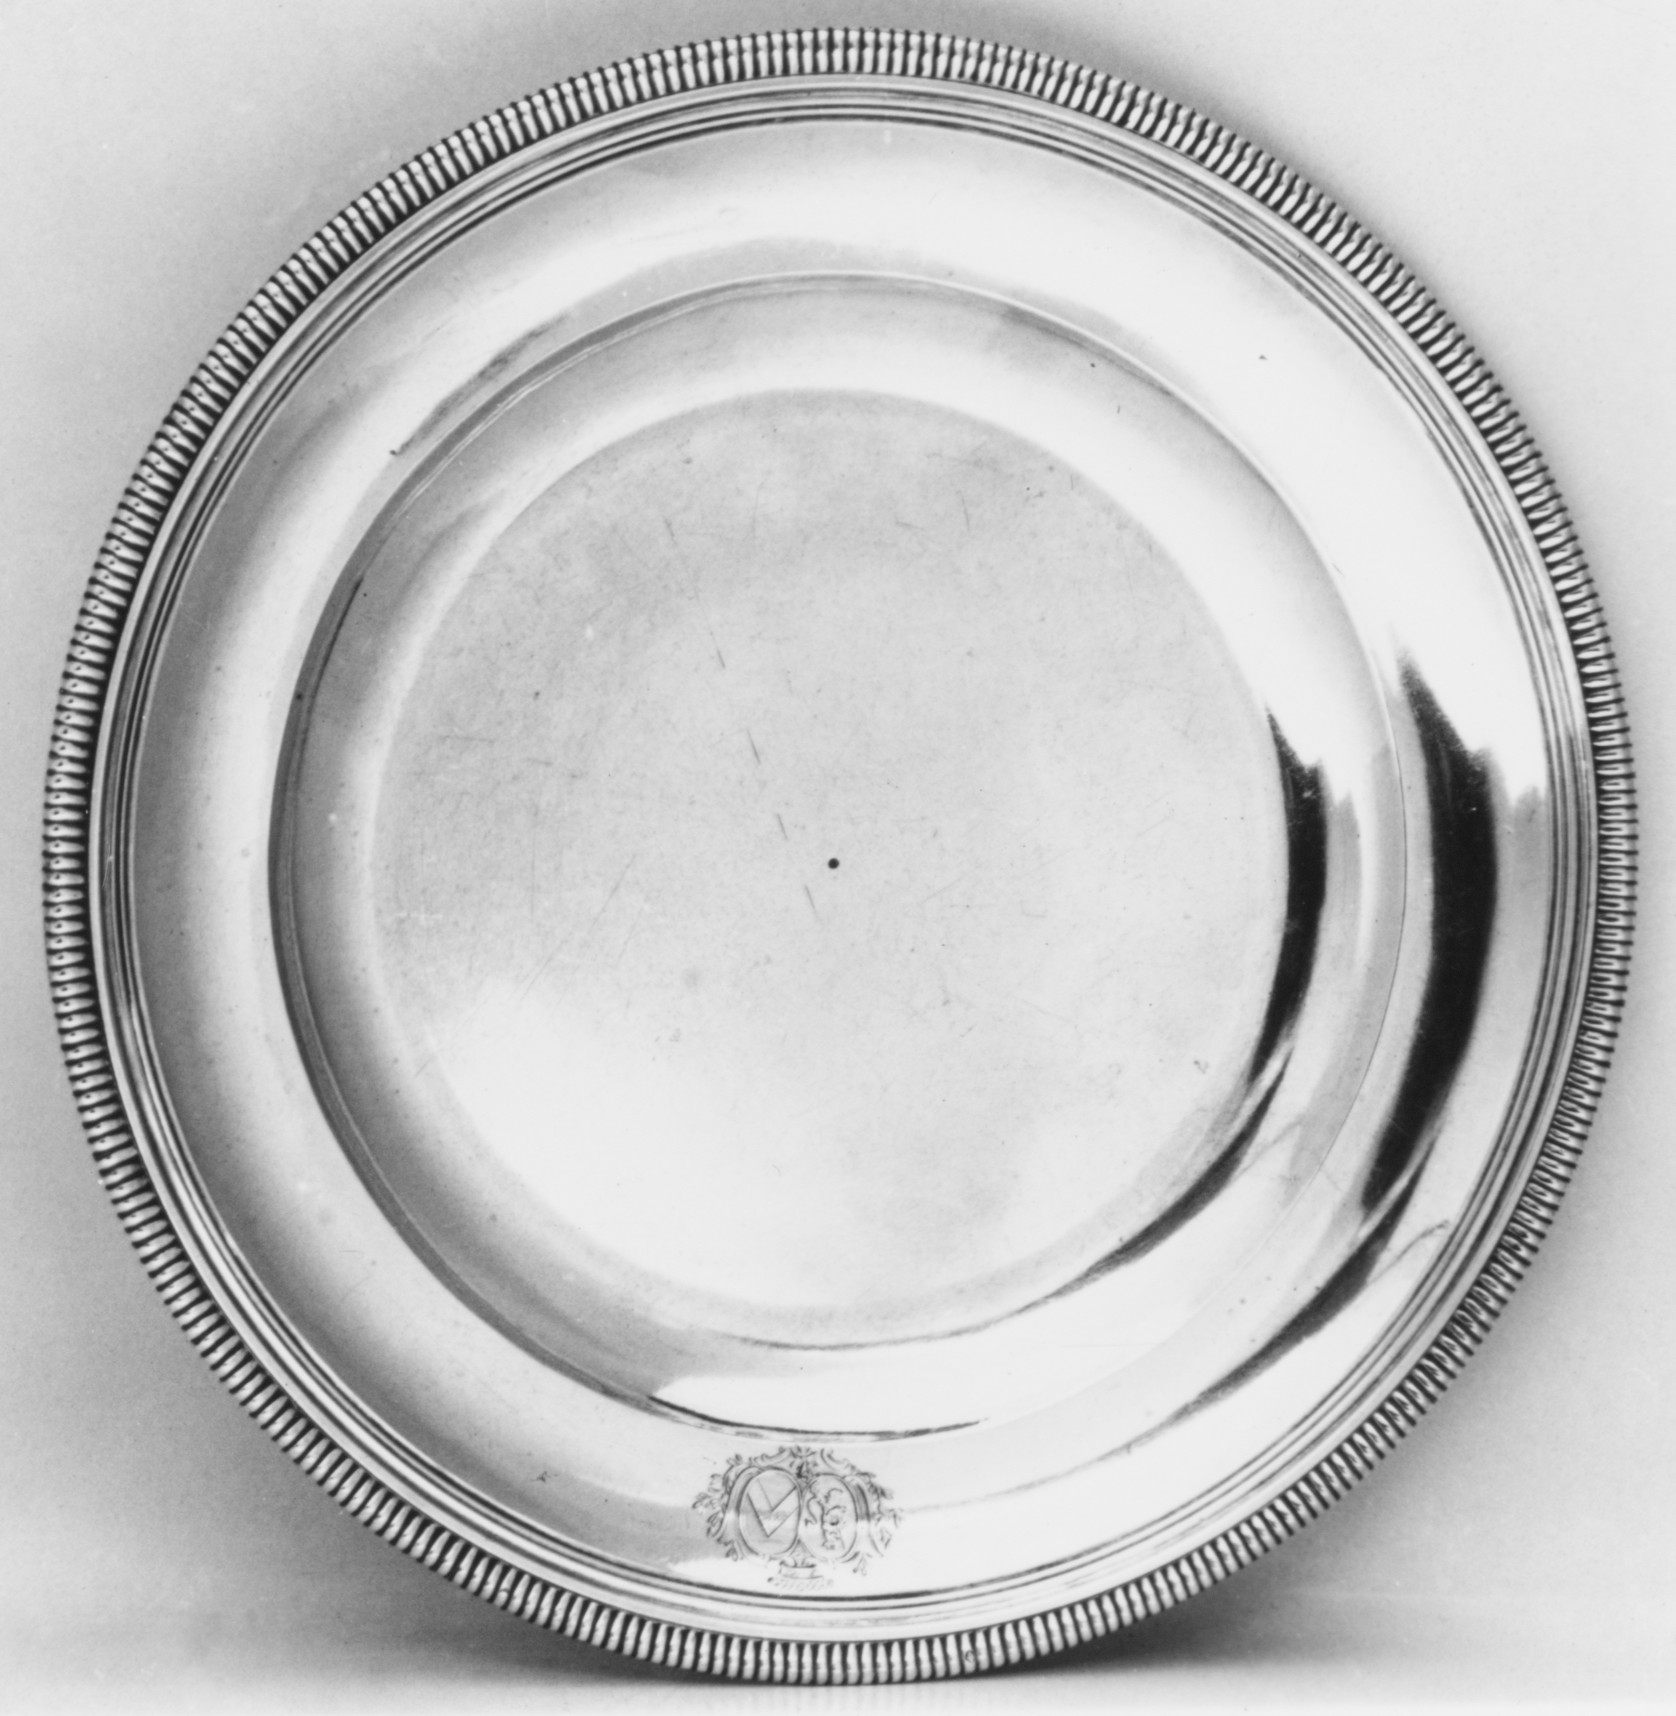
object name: plate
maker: edme-pierre balzac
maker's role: maker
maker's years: 1705-1786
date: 1771-1772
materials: silver